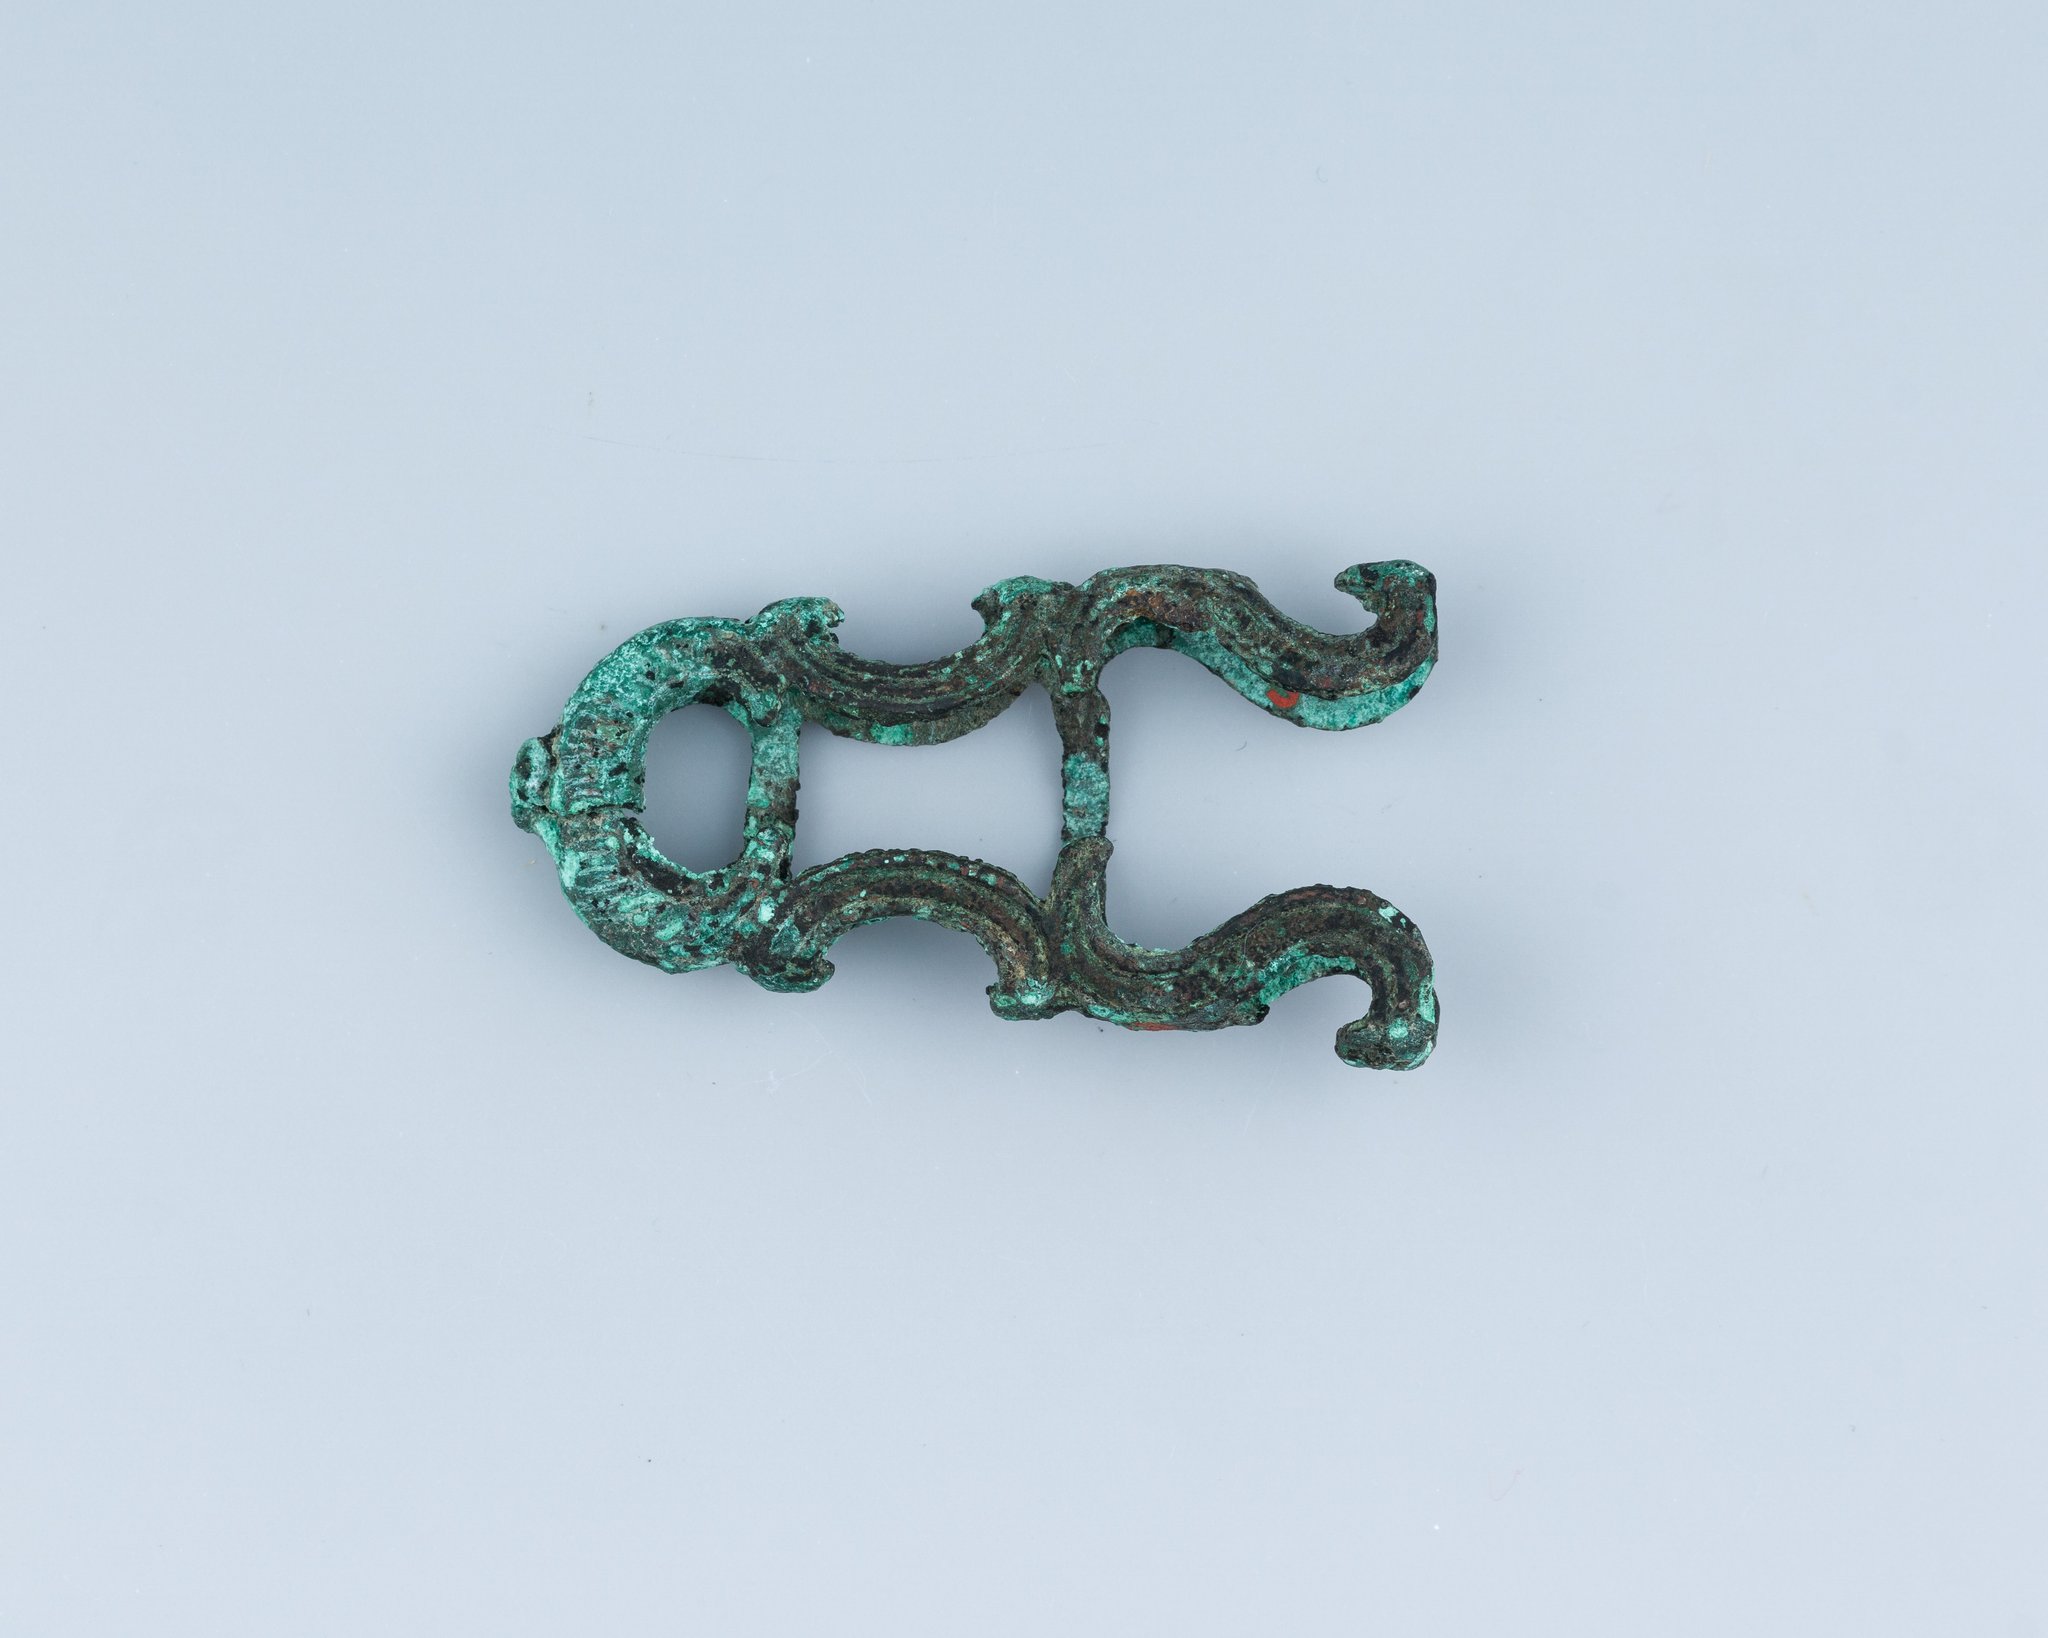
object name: mordant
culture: european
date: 1401-1700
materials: bronze, patina